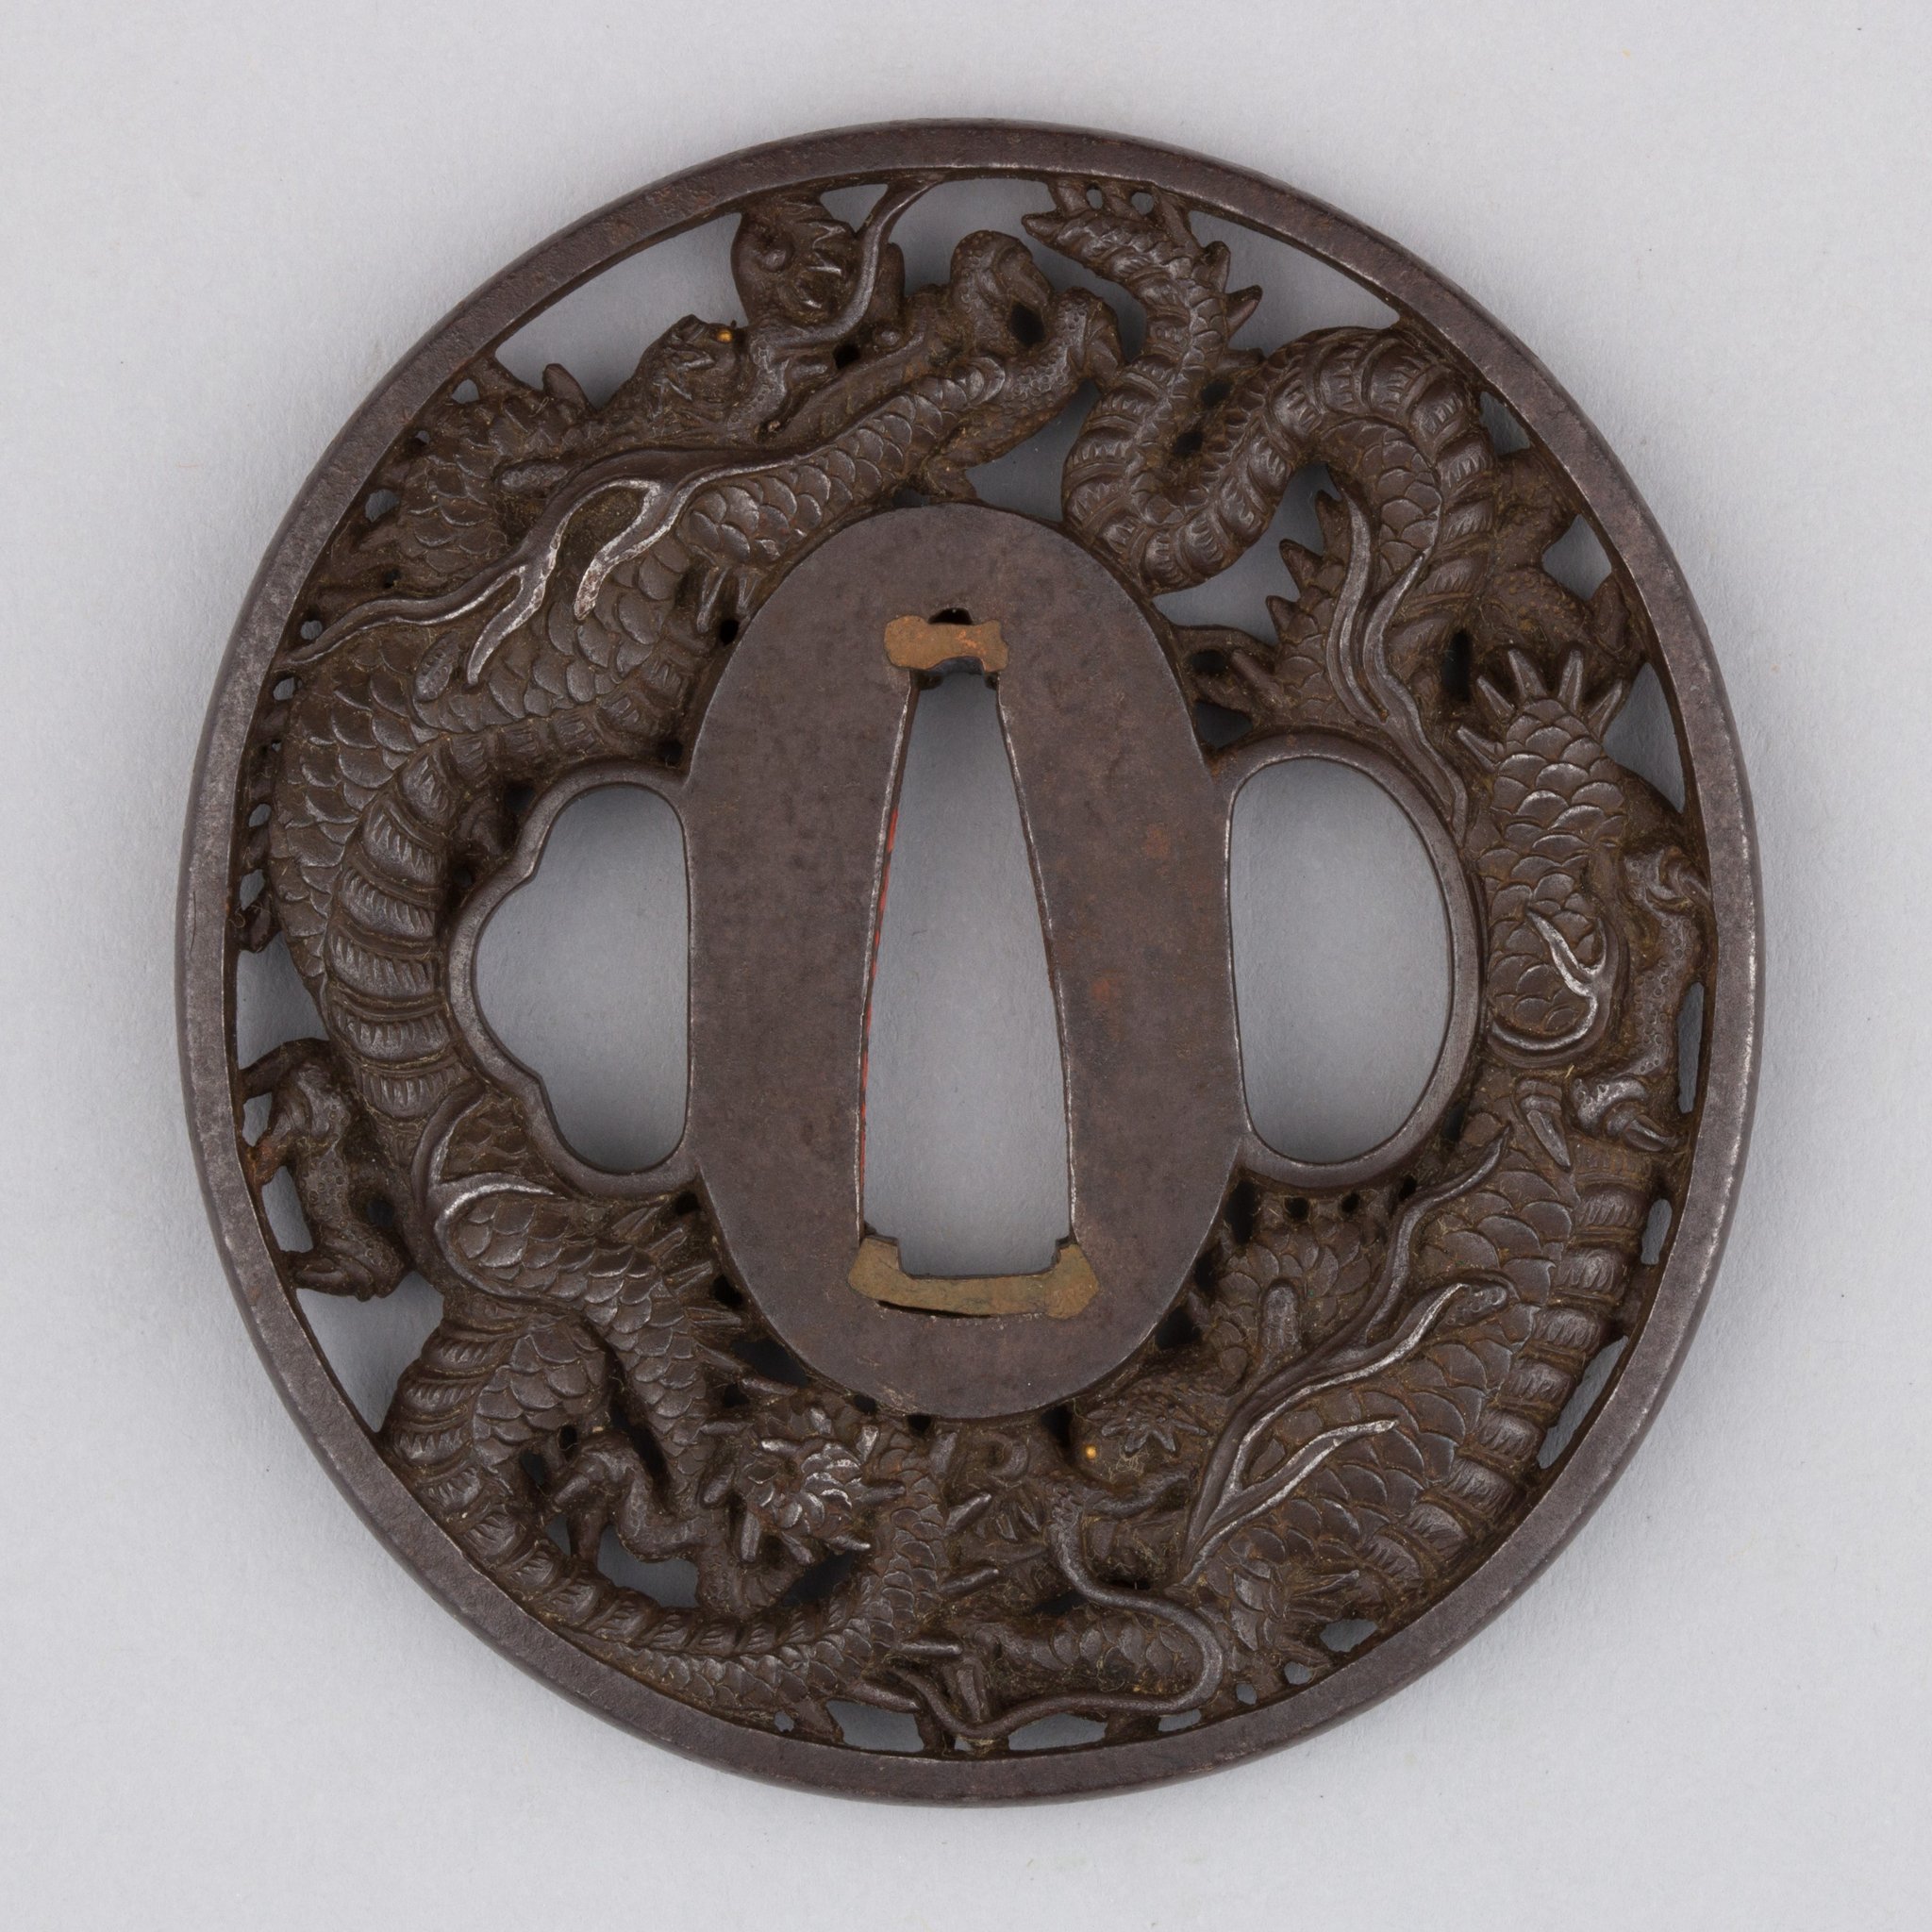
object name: sword guard tsuba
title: Sword Guard (Tsuba)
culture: japanese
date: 1801-1900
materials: copper, gold, iron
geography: japan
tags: dragons